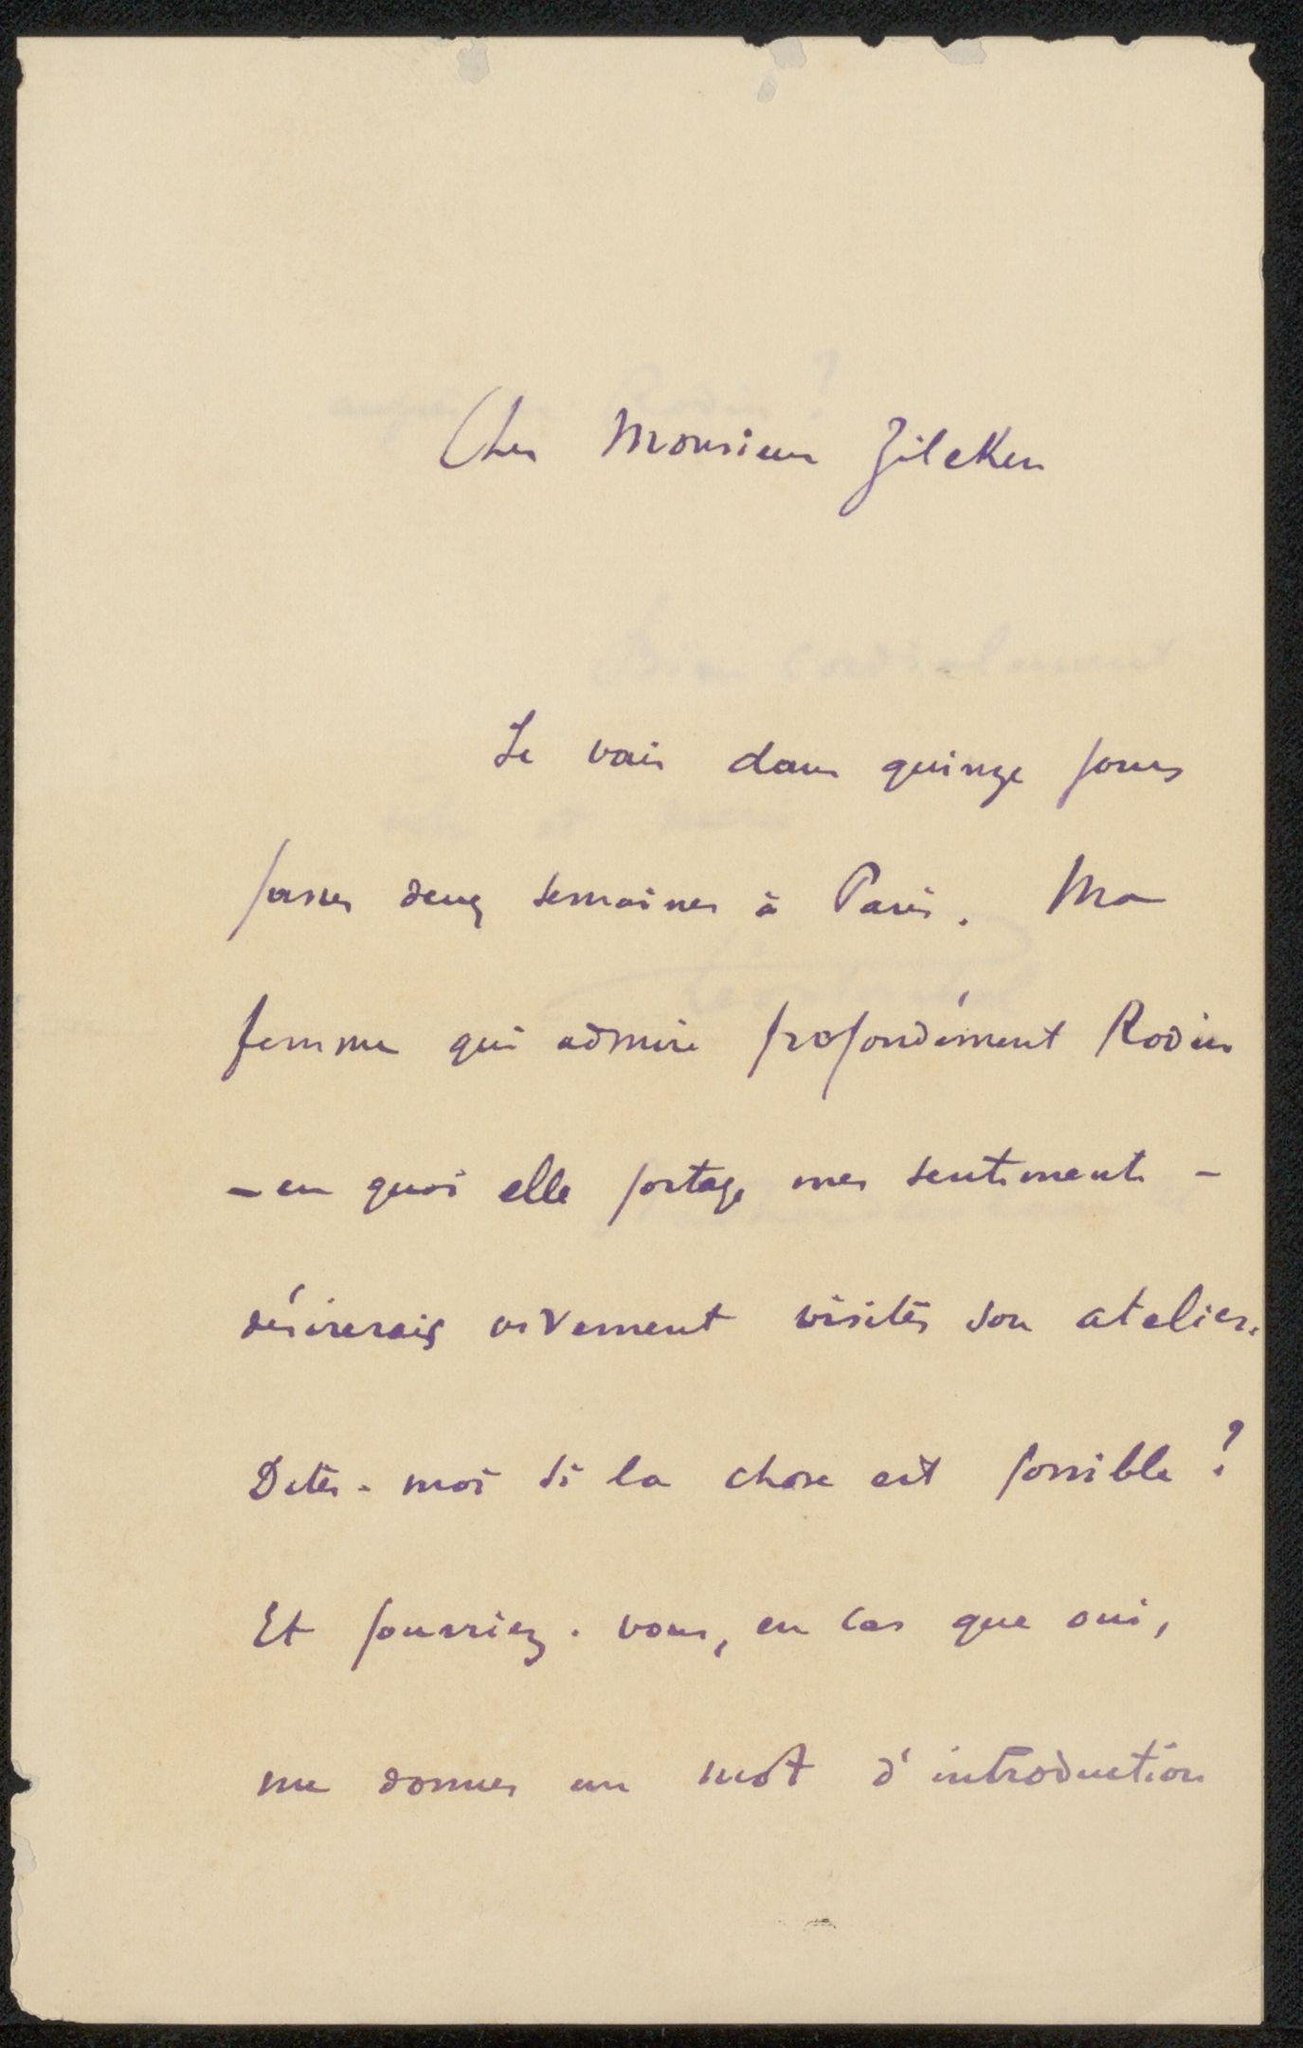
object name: letter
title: Brief aan Philip Zilcken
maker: léon paschal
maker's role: schrijver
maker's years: 1873-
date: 1901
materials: ink, paper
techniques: pen, writing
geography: the hague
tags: paris, print maker, auguste rodin, painter, draughtsman, philip zilcken, workshop, studio of the artist (in general)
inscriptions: collector's mark: ‘RPK’